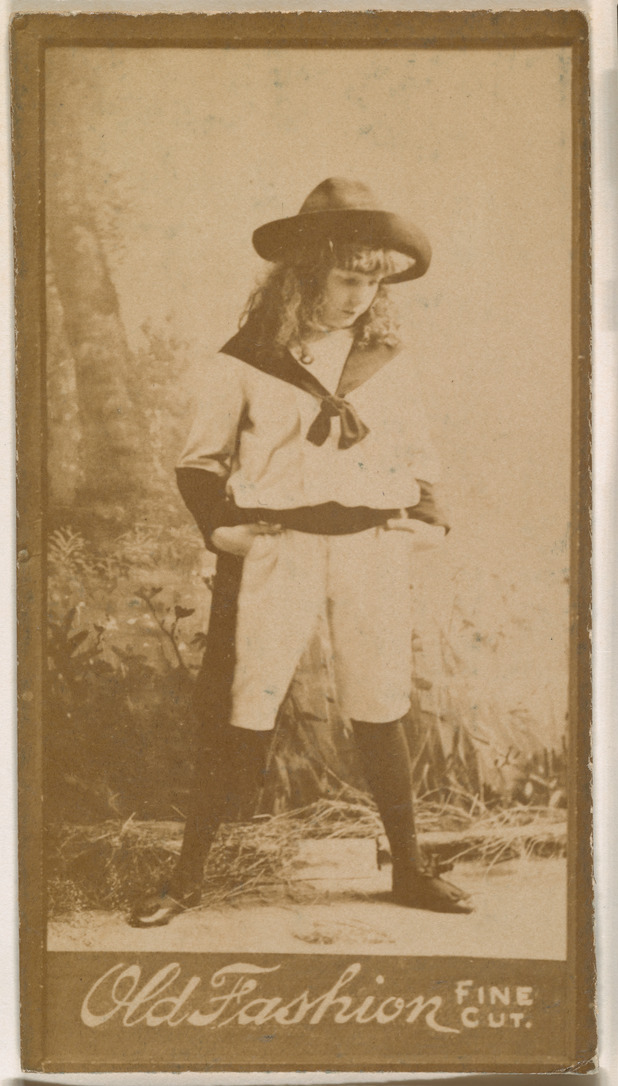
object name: photograph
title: Actress wearing sailor costume, from the Actresses series (N664) promoting Old Fashion Fine Cut Tobacco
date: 1888-1890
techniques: albumen silver print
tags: girls,portraits,actresses